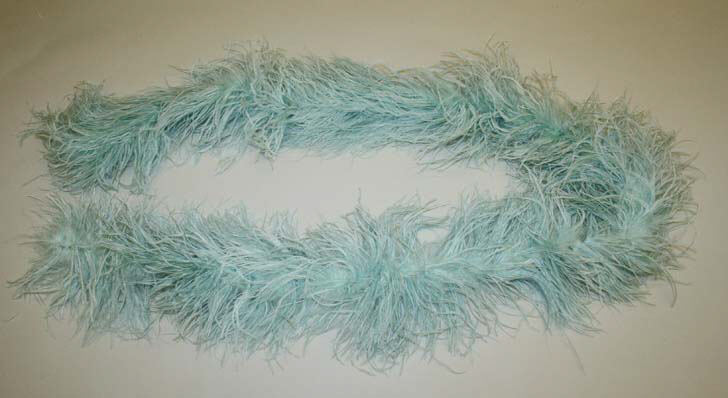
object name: boa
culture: american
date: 1890-1899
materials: feather